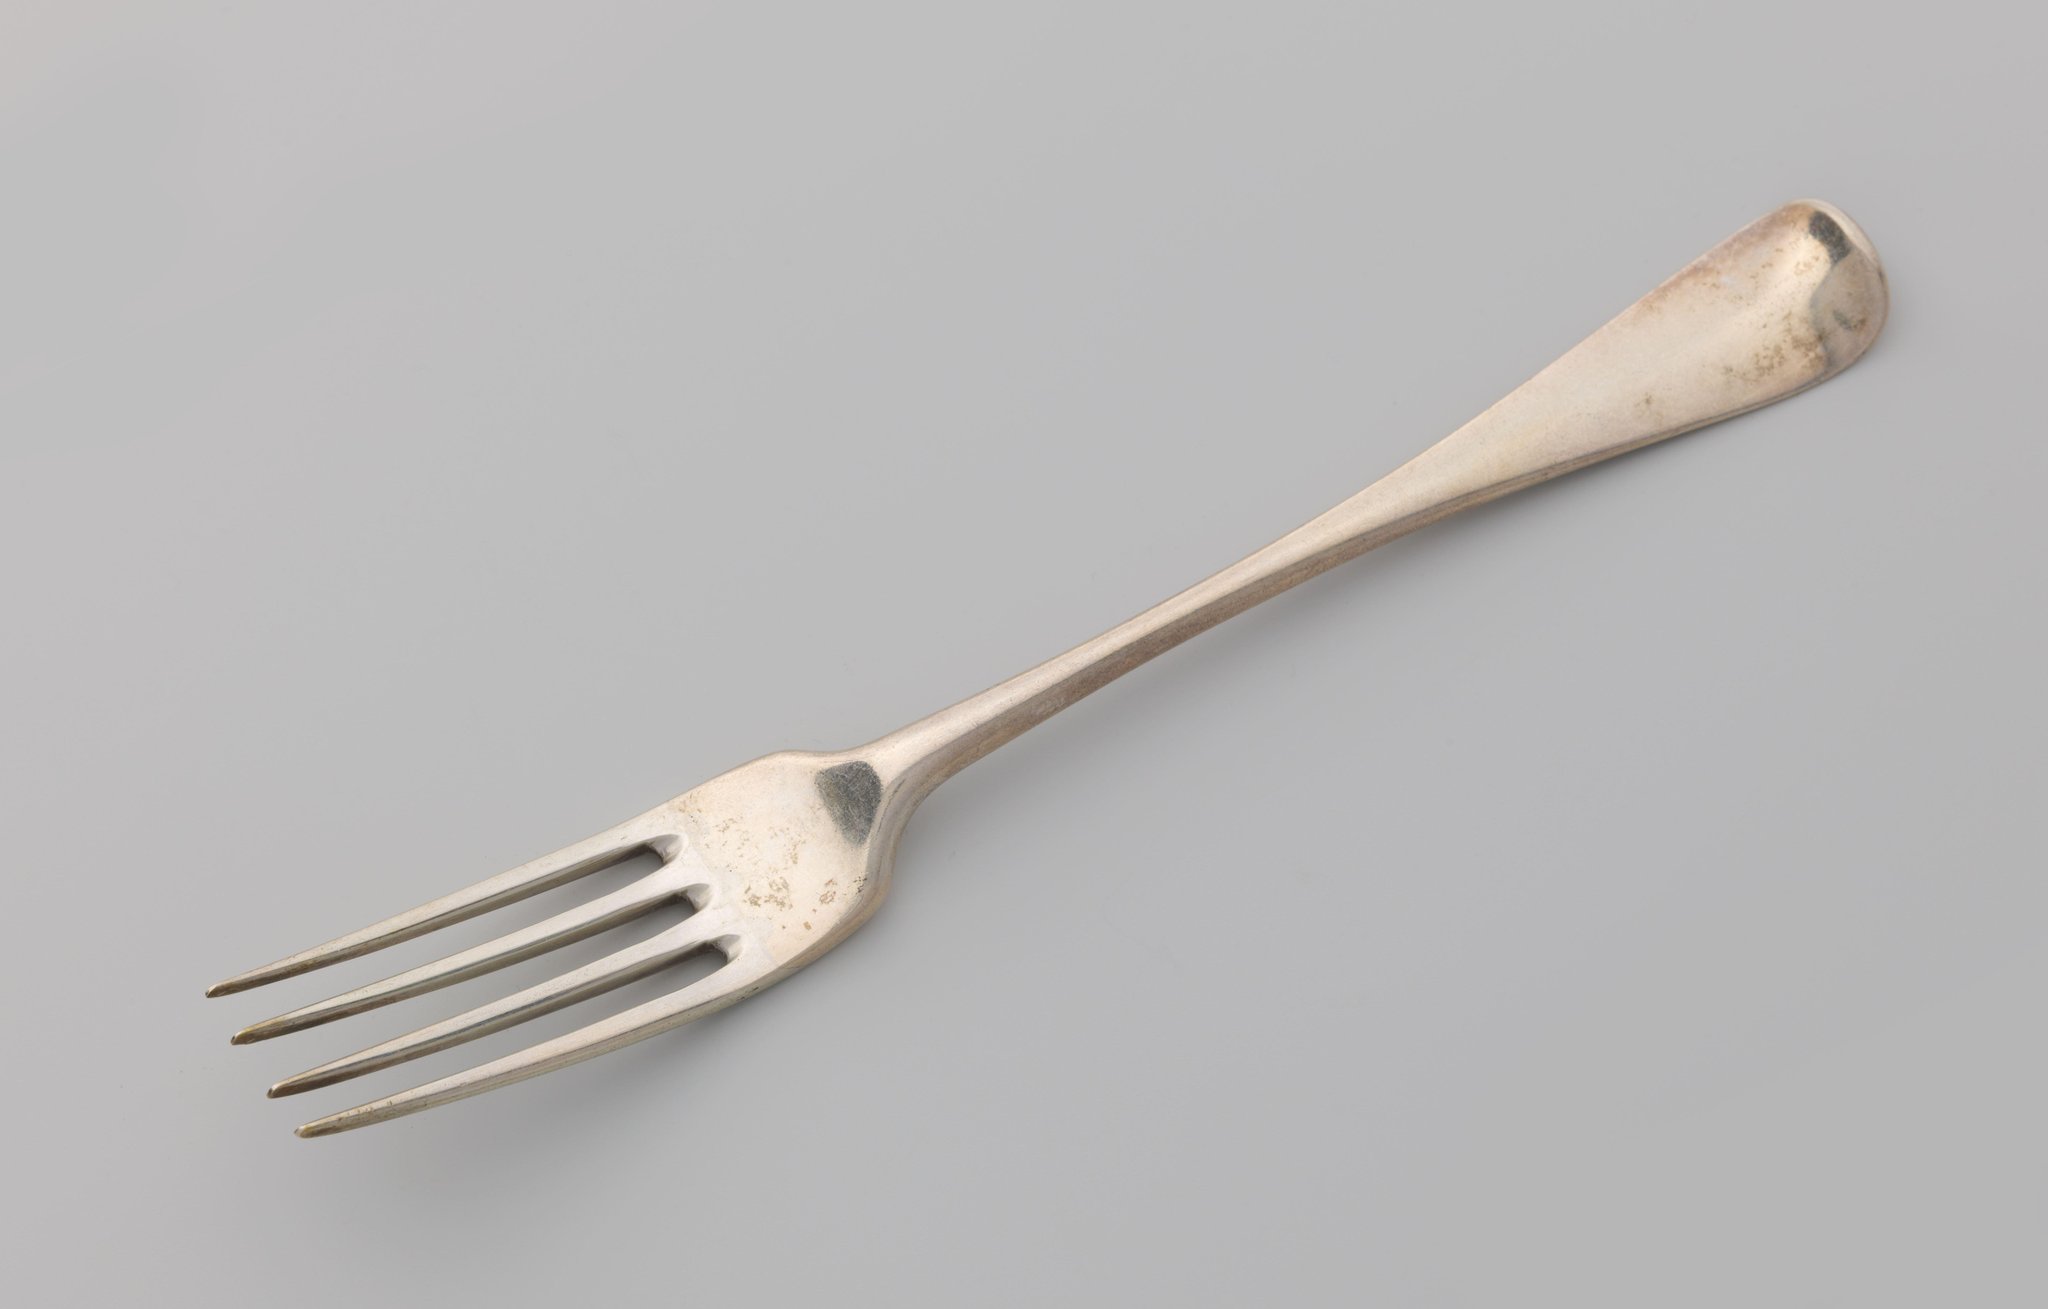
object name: fork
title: Vork van zilver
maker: dirk van gameren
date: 1764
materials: silver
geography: utrecht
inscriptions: mark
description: Vork van zilver, met 4 tanden. De vork gaat geleidelijk over in de platte steel die zich verbreedt naar het afgeronde uiteinde.